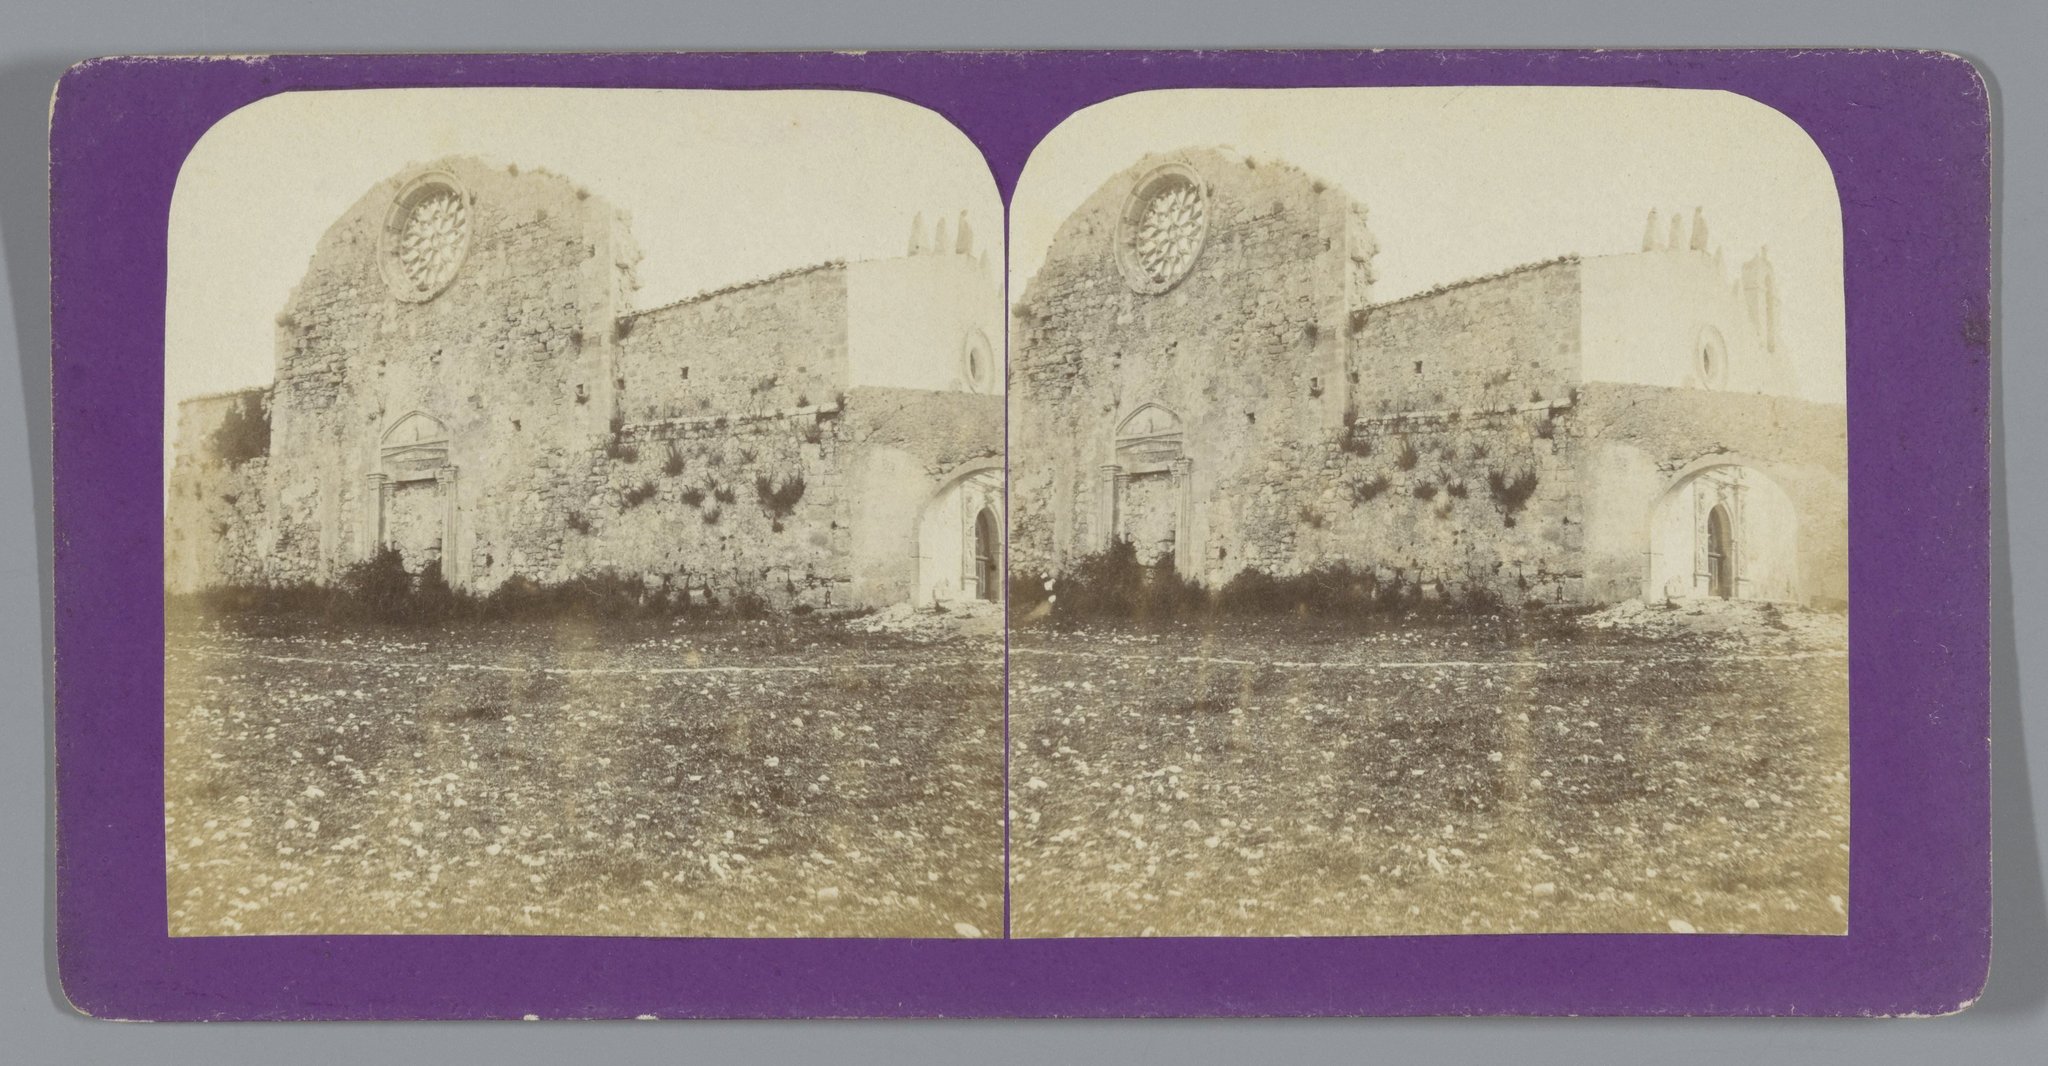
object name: stereograph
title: Gezicht op de Chiesa di San Giovannello te Syracuse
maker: jean andrieu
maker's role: fotograaf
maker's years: 1816-1872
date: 1862-1876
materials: cardboard, paper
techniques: albumen print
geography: syracuse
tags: abbey, monastery, convent ~ roman catholic church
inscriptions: title: ‘1362 église St Jean Syracuse’